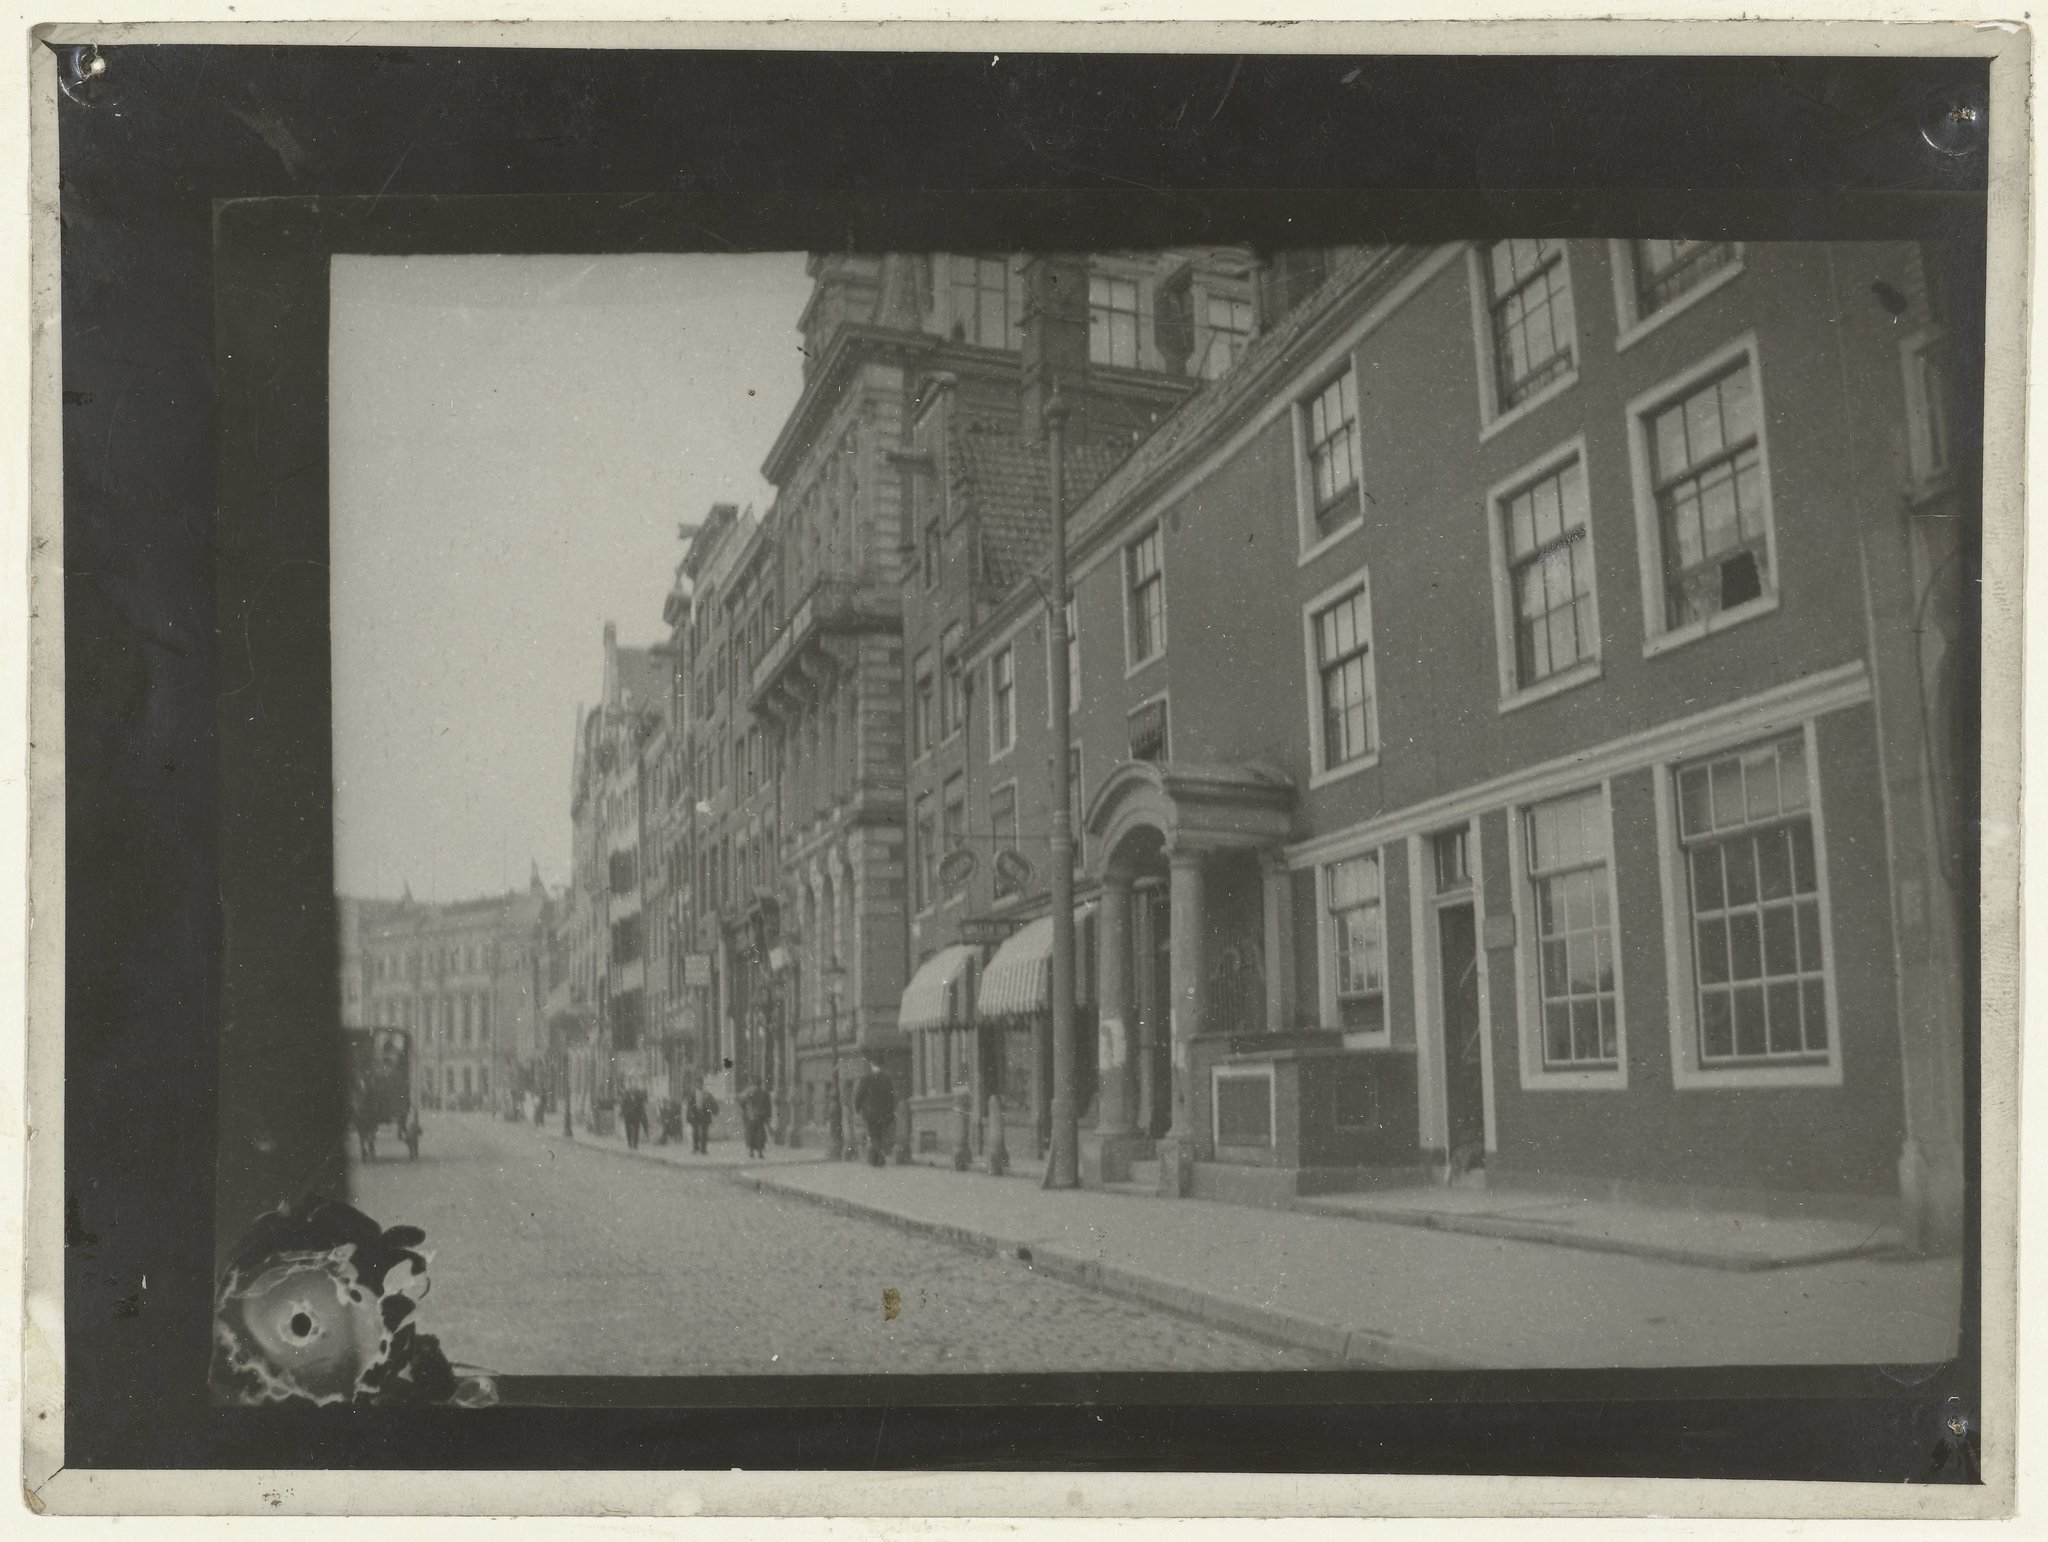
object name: photograph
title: Gezicht op het Rokin te Amsterdam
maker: george hendrik breitner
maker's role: draughtsman, painter, print maker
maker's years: 1857-1923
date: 1904-1908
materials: cardboard, photographic support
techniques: gelatin silver print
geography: amsterdam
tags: street, amsterdam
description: Vooraan de ingang van de Nieuwezijds Kapel (Rokin 78-80). In de verte kunstenaarsvereniging Arti et Amicitiae (Rokin 112).